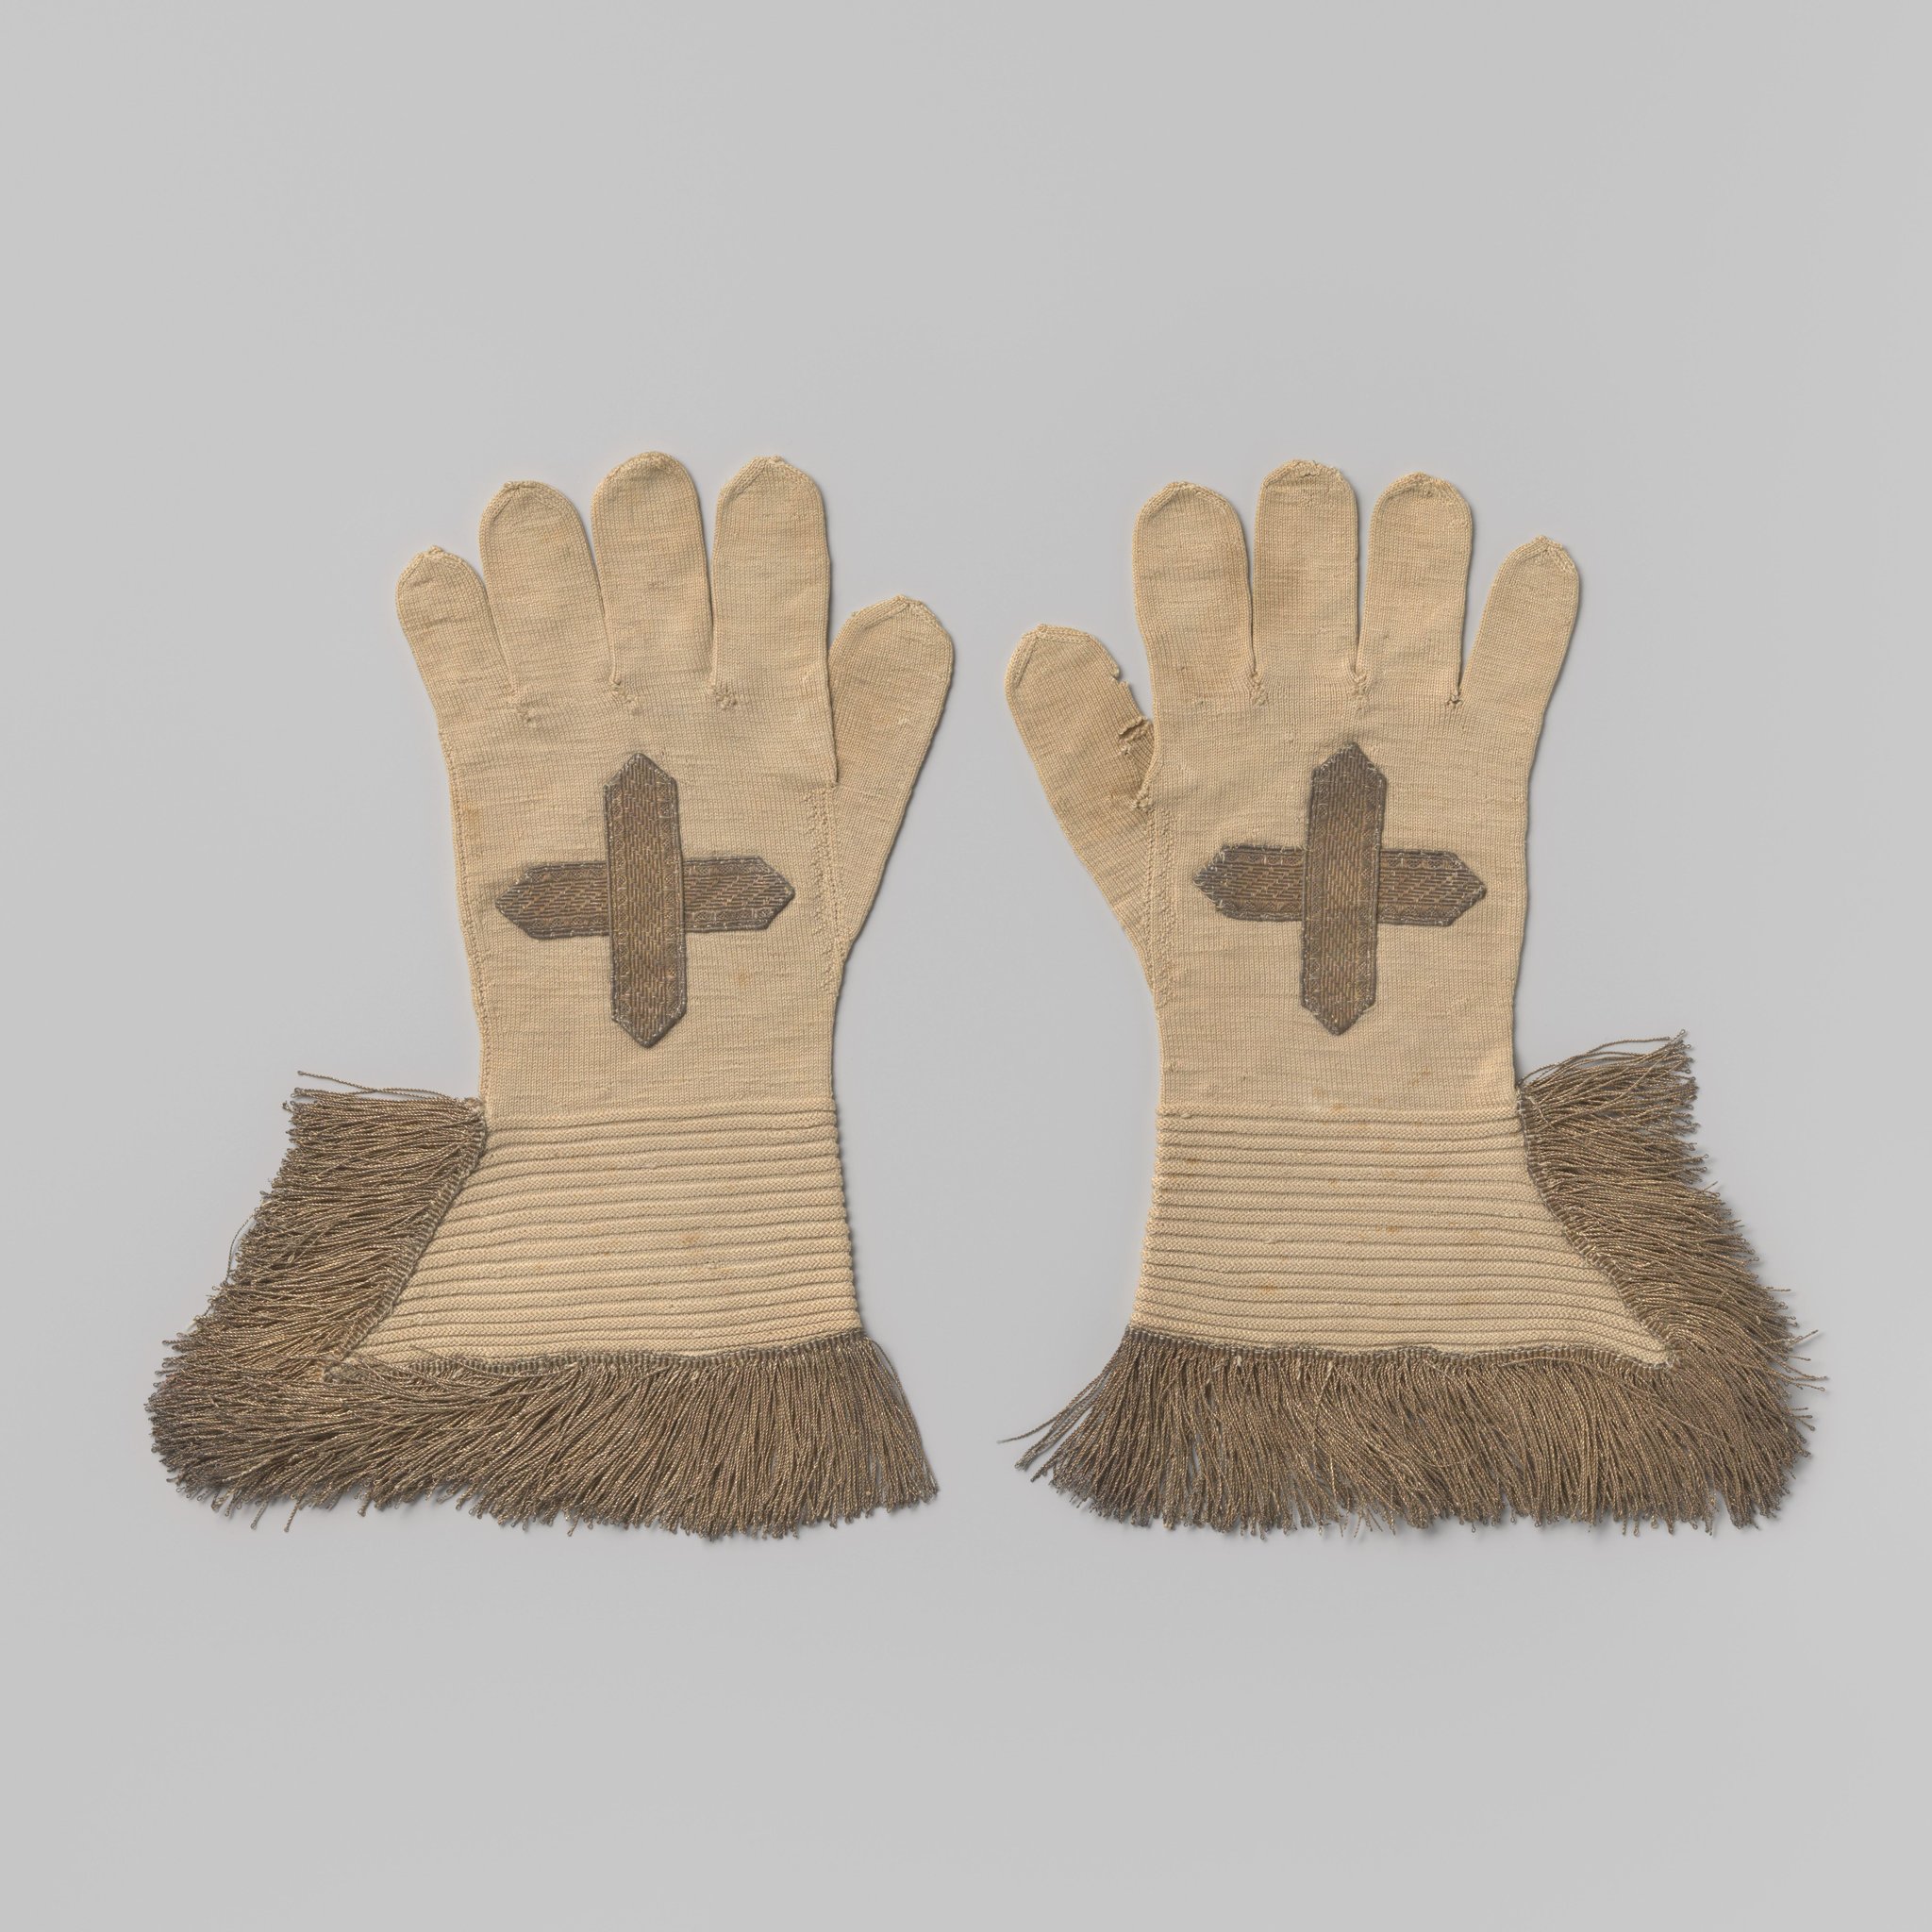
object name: liturgical costume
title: Handschoenen beige van gebreide zijde, versierd met gouden stikwerk en franje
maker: Anonymous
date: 1750-1800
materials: metal thread, silk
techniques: knitting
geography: western europe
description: Linkerhandschoen van gebreide zijde. Voor priester handschoenen met gouden stikwerk en franje.